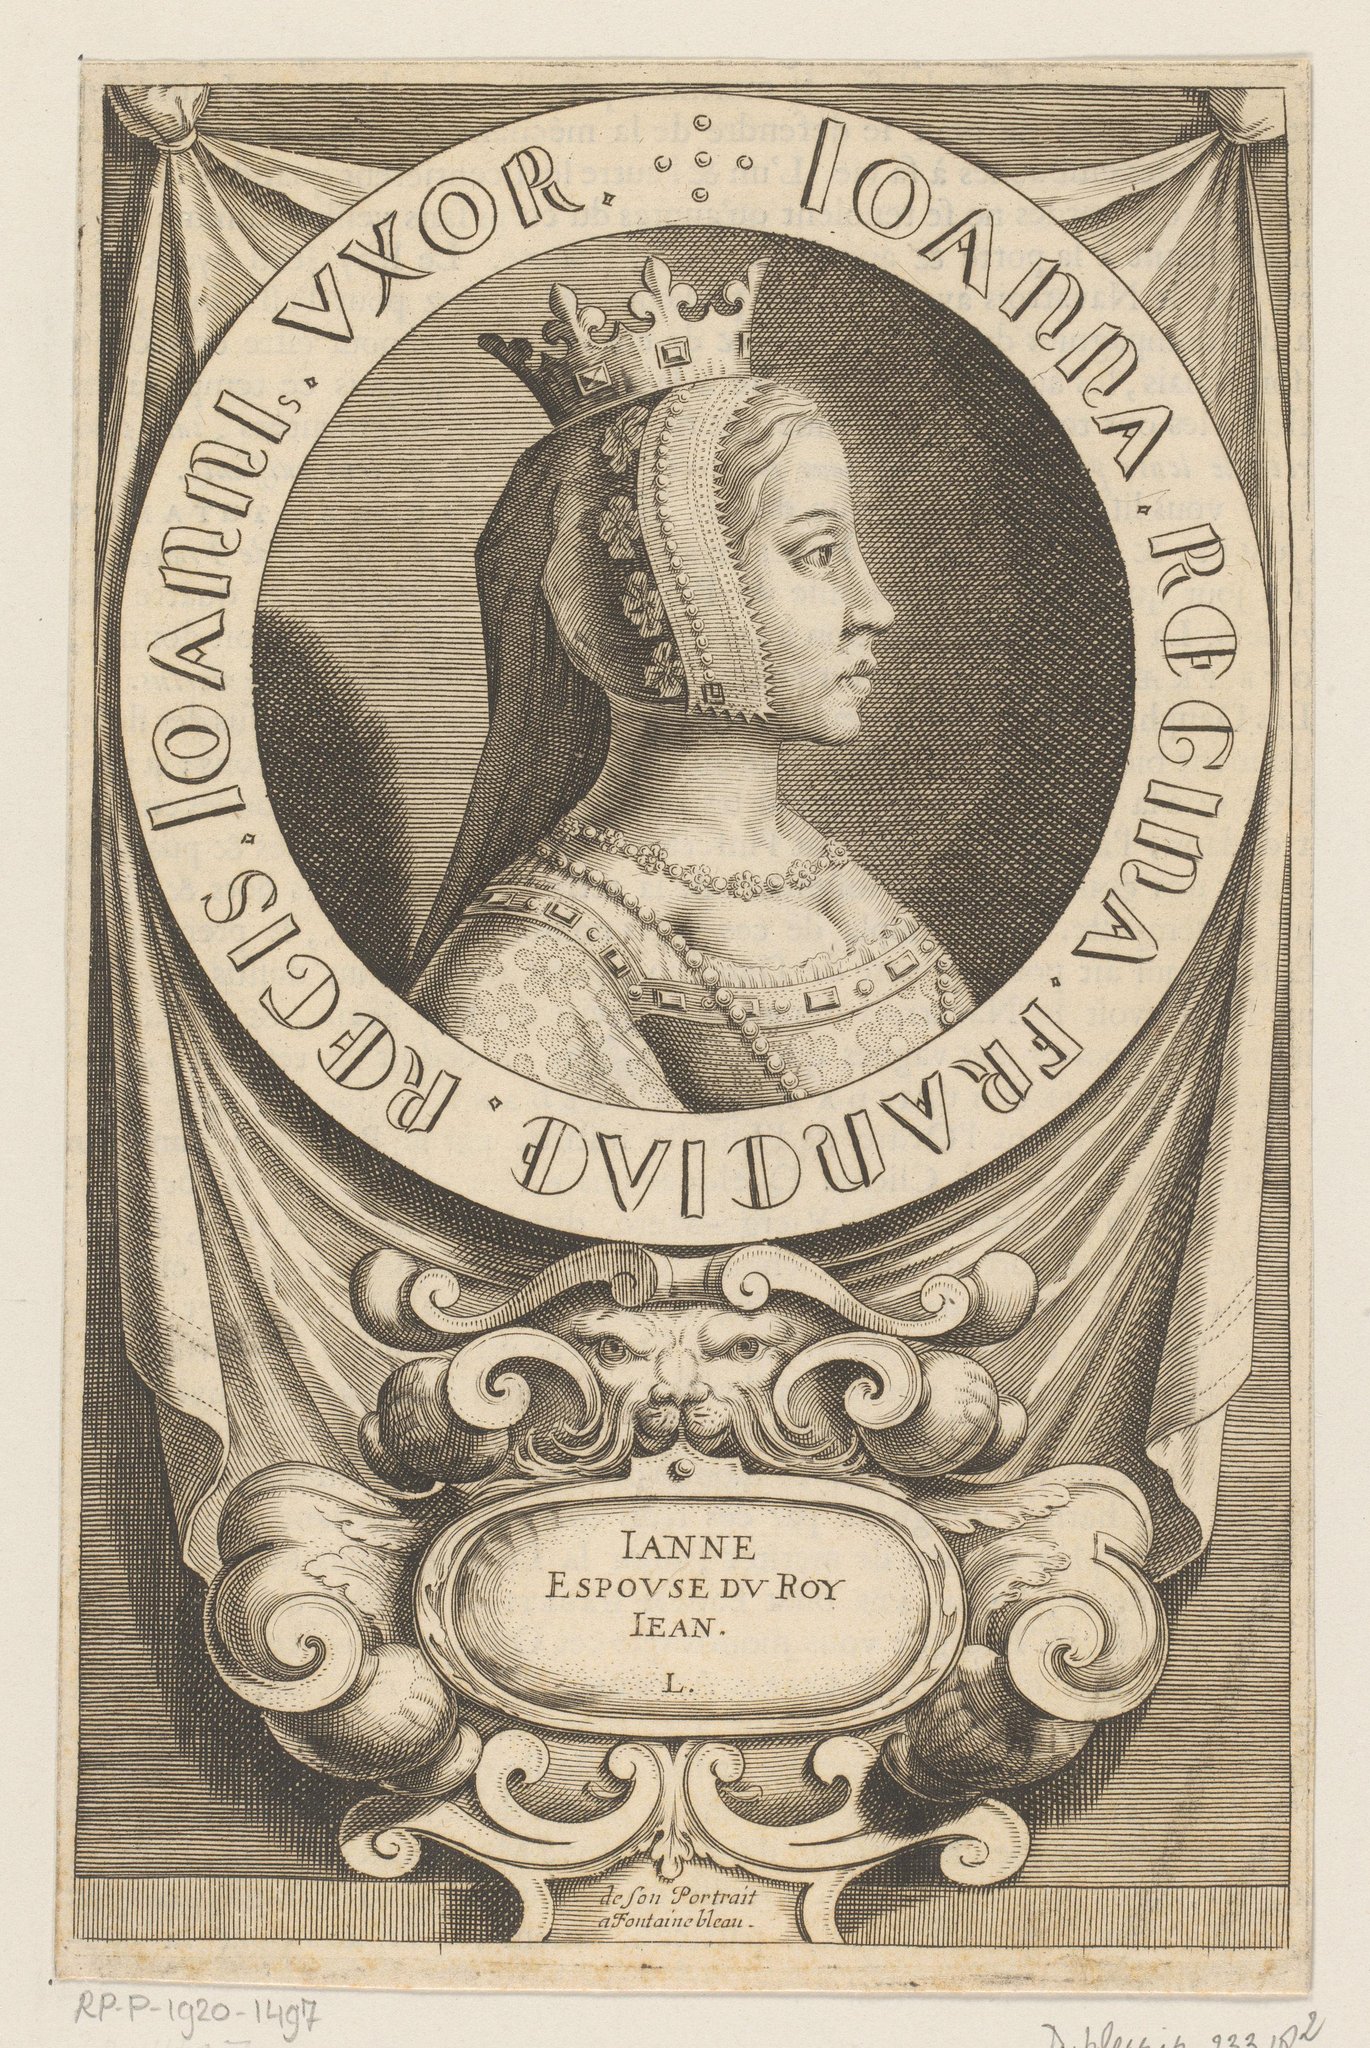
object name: print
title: Portret van Johanna I van Auvergne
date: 1635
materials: paper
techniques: engraving, letterpress printing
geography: paris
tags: historical persons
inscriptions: collector's mark: Lugt 2228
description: Prent uit: Eudes de Mézeray, François. Histoire de France, depuis Faramond jusqu’au regne de Louis le Juste (...). 3 dln. Parijs: Denis Thierry, Jean Guignard en Claude Barbin, 1635, dl. 2. Prent waarschijnlijk voor het eerst verschenen in: Bie, Jacques de. Les vrais portraits des rois de France (...). Parijs: Jacques de Bie en Pierre Rocolet, 1634. Prent ook gebruikt in latere publicaties.